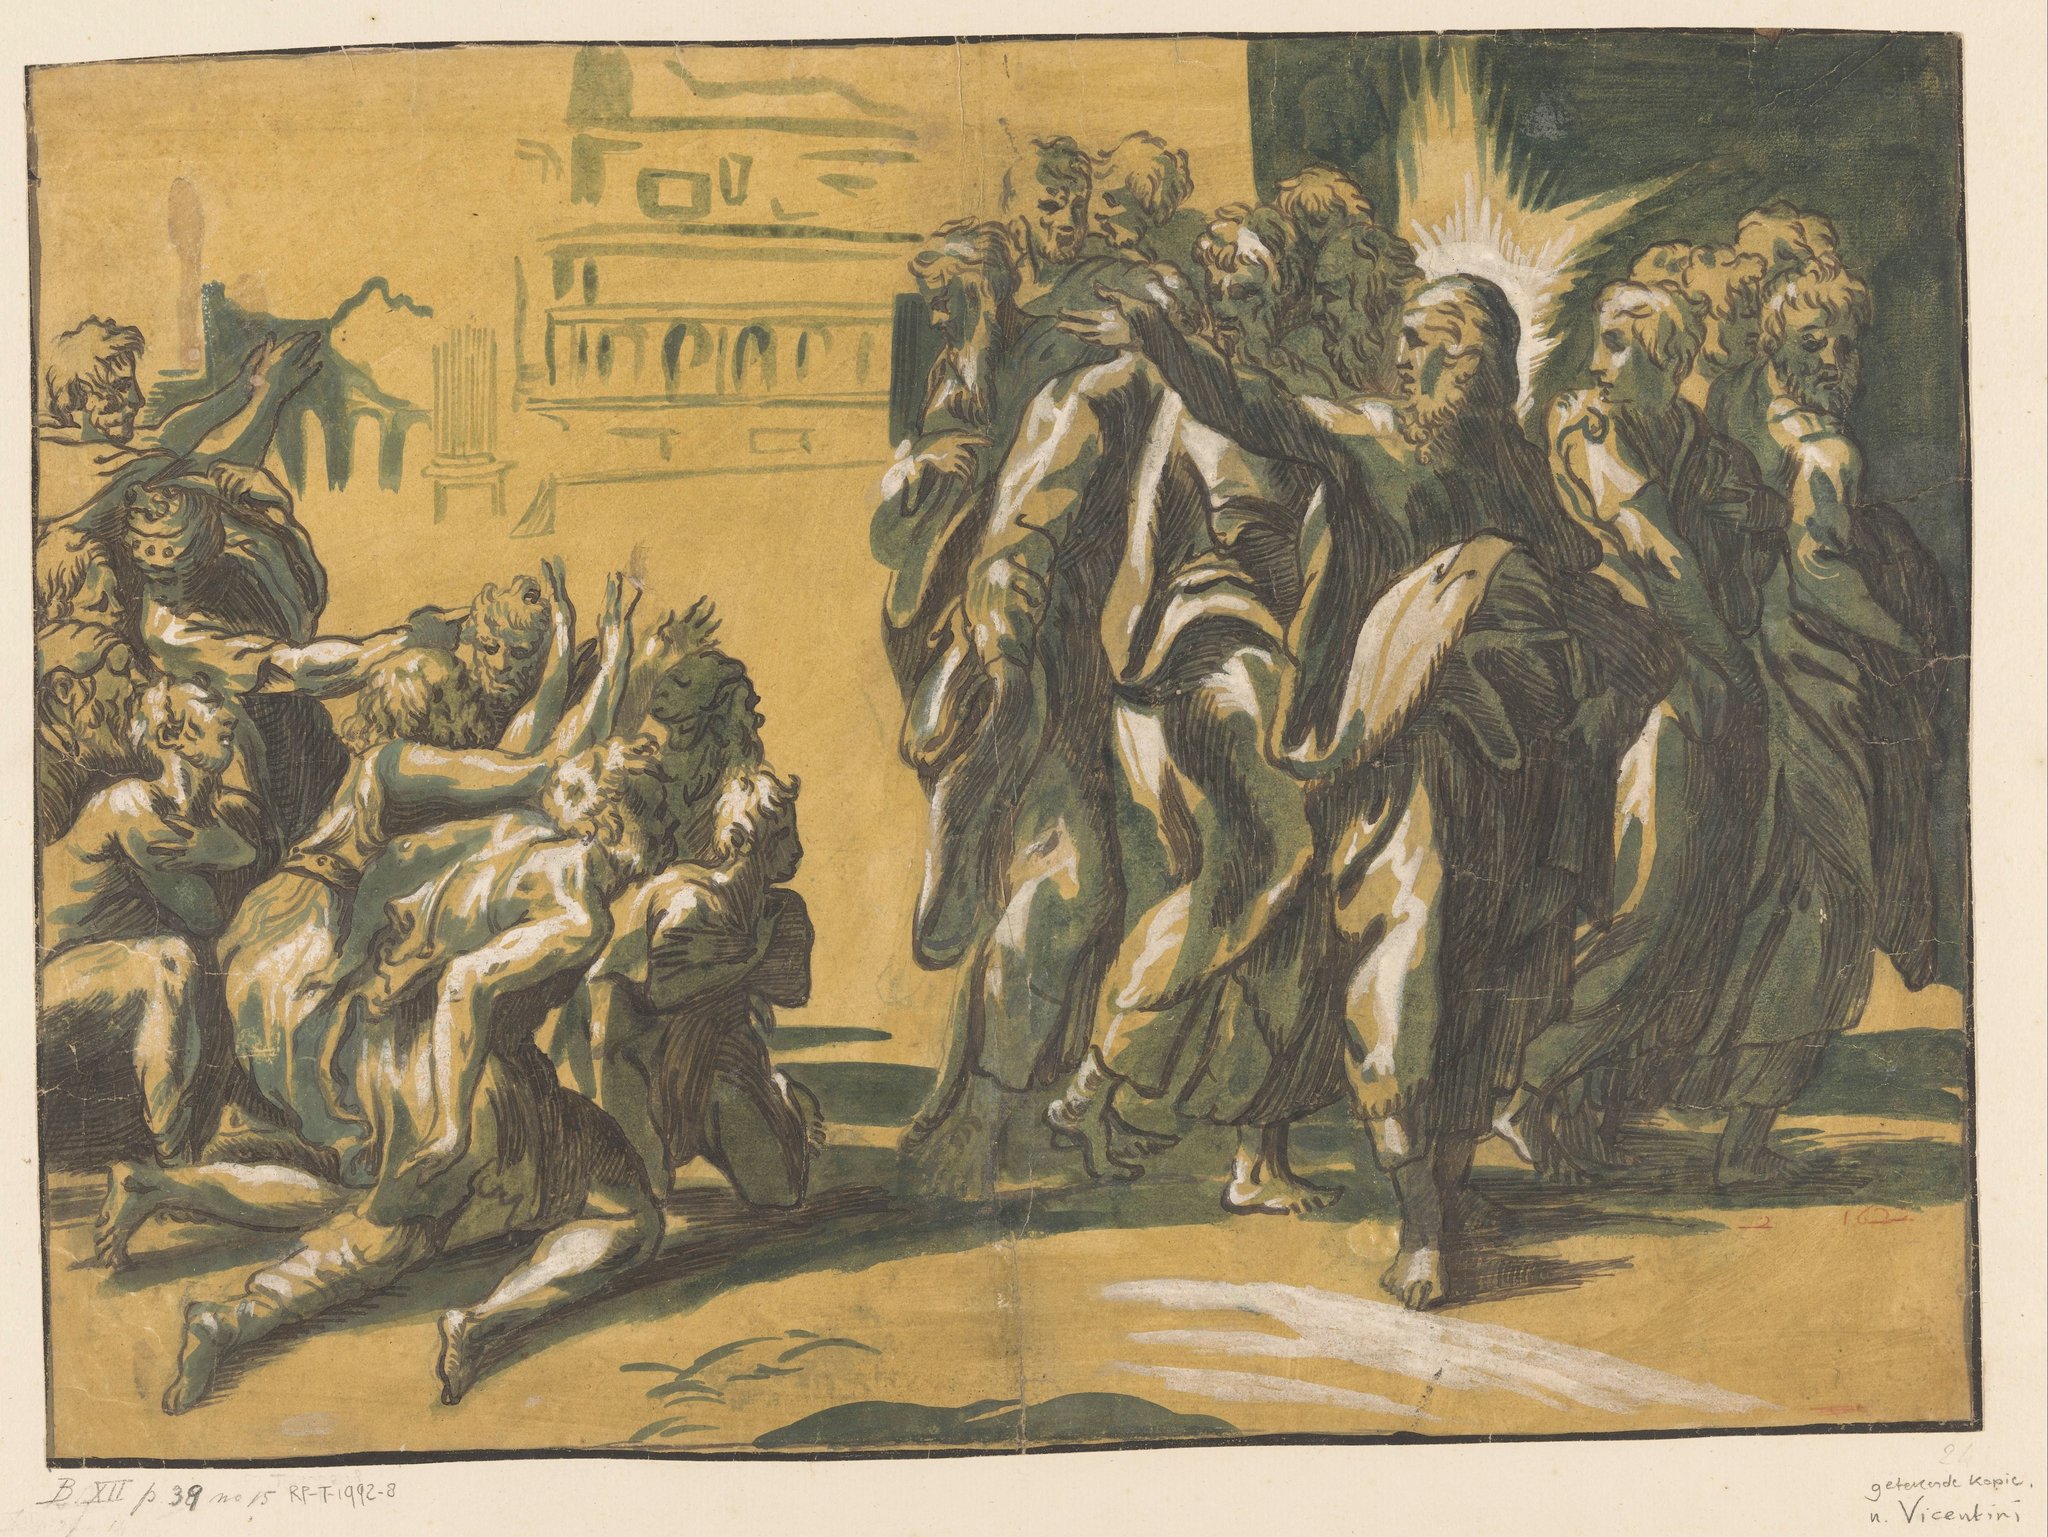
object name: drawing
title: Christus geneest melaatsen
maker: Anonymous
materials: paint, ink, paper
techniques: brush, pen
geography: italy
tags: christ healing lepers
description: Christus met de apostelen en een groep smekende melaatsen.